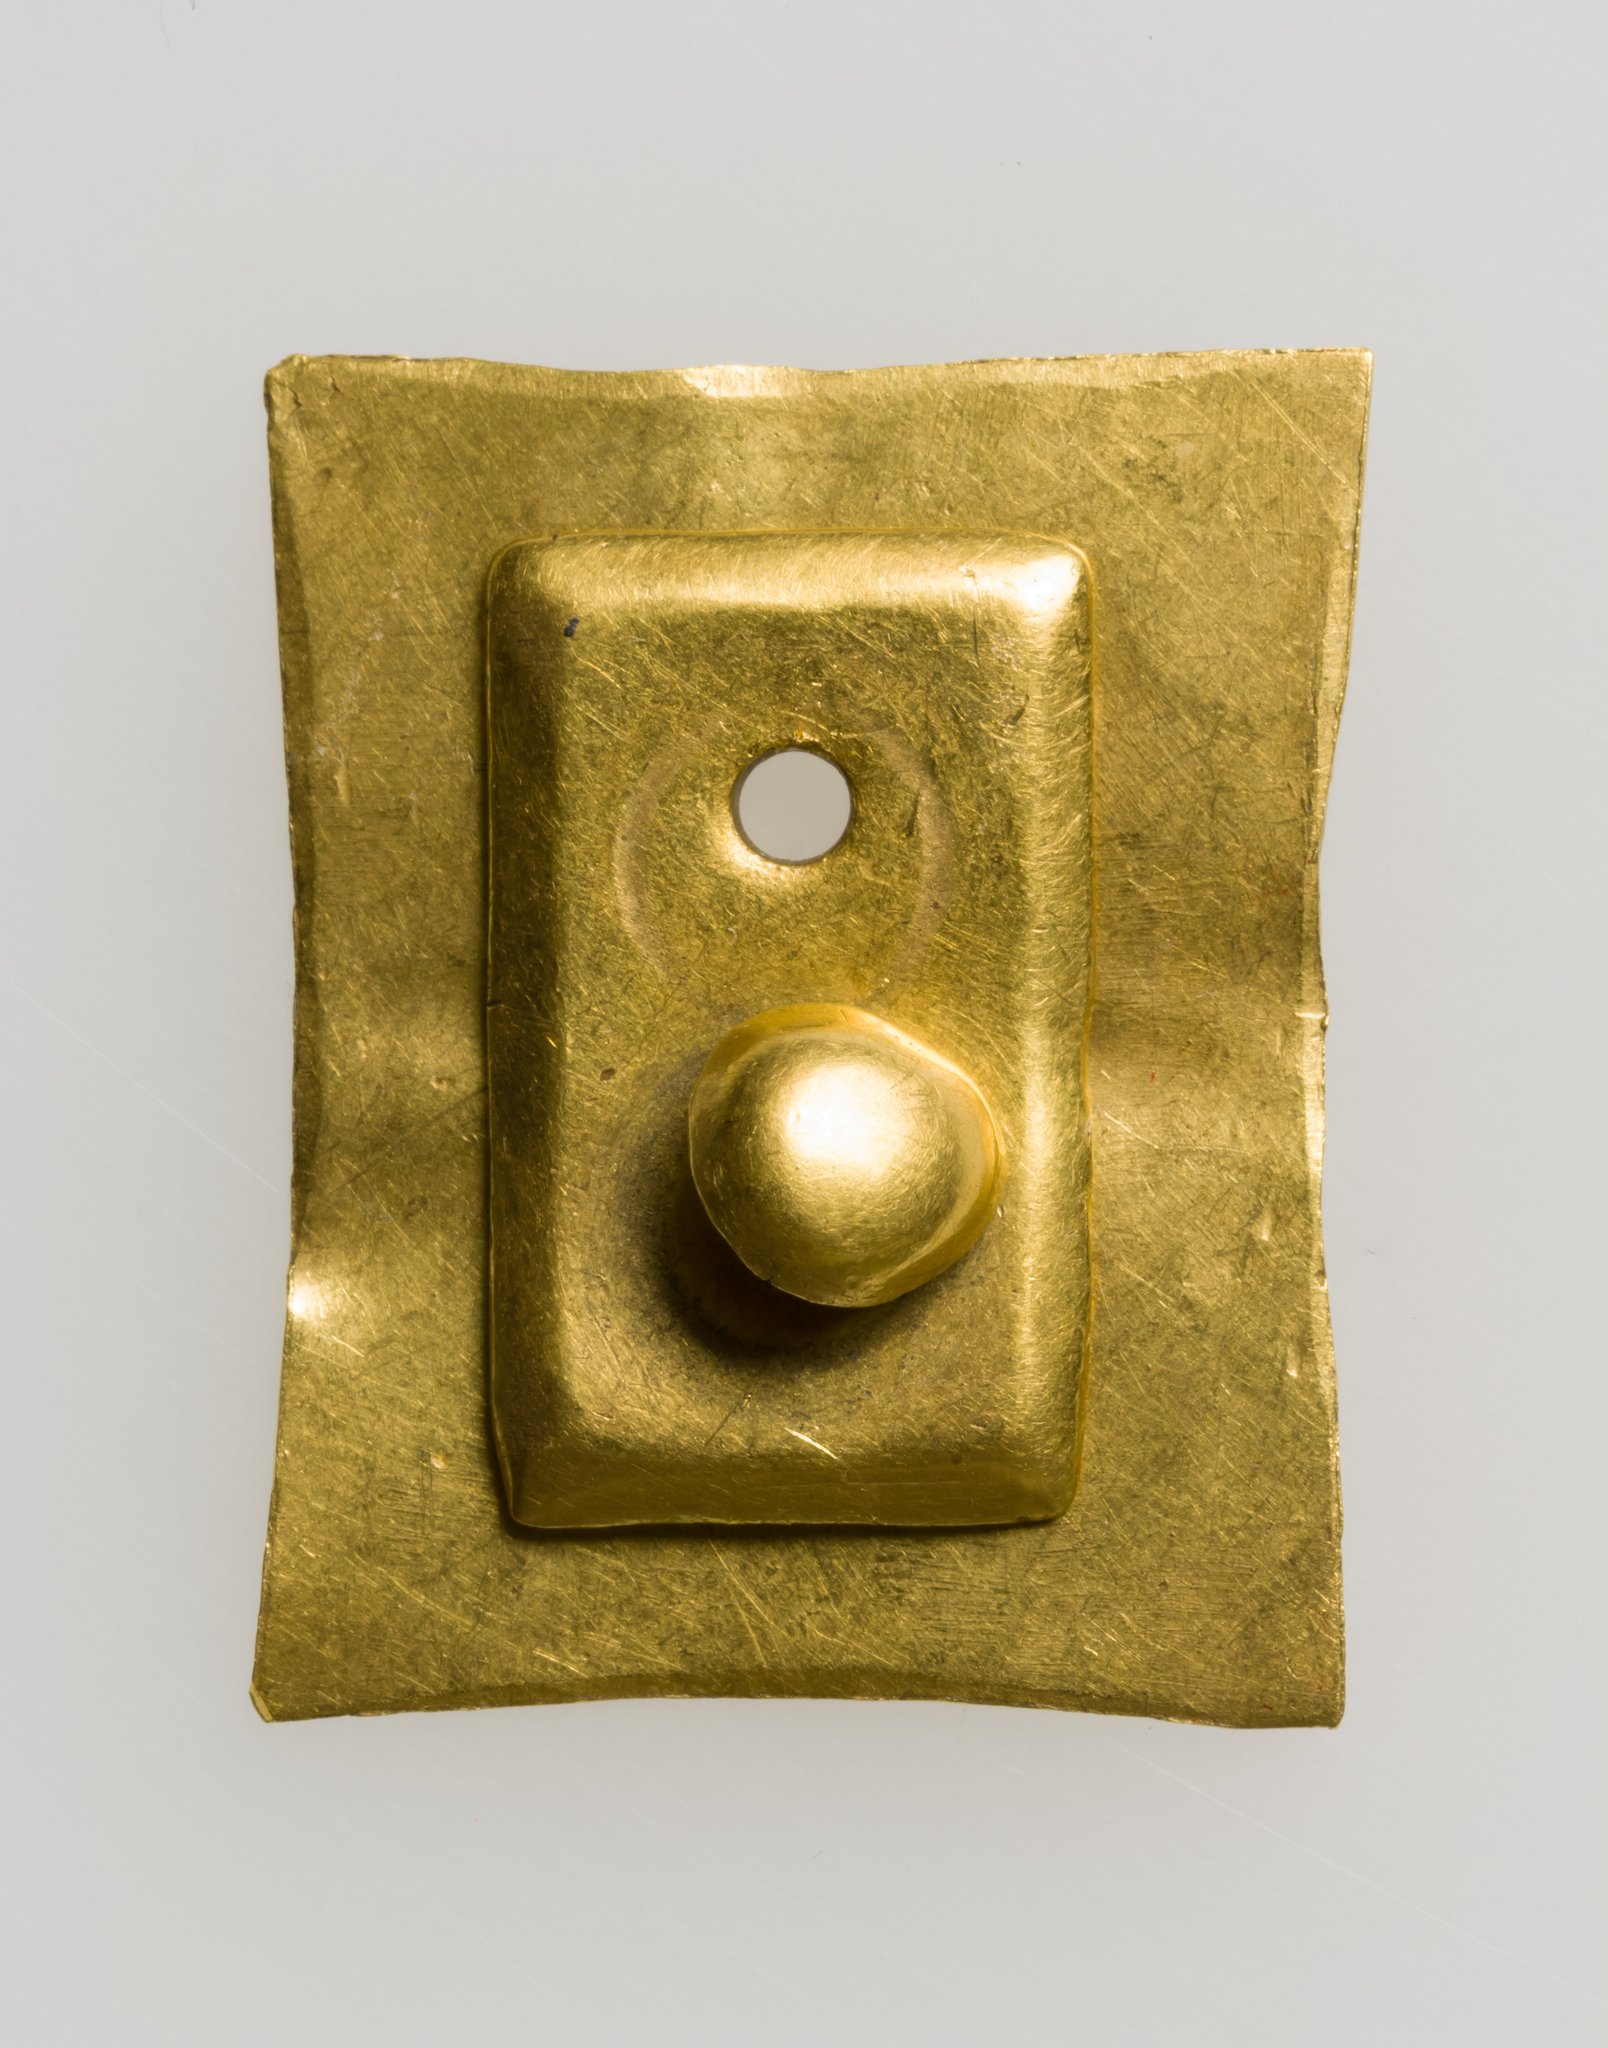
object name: belt mount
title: Gold Belt Mount with Rivet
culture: avar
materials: gold